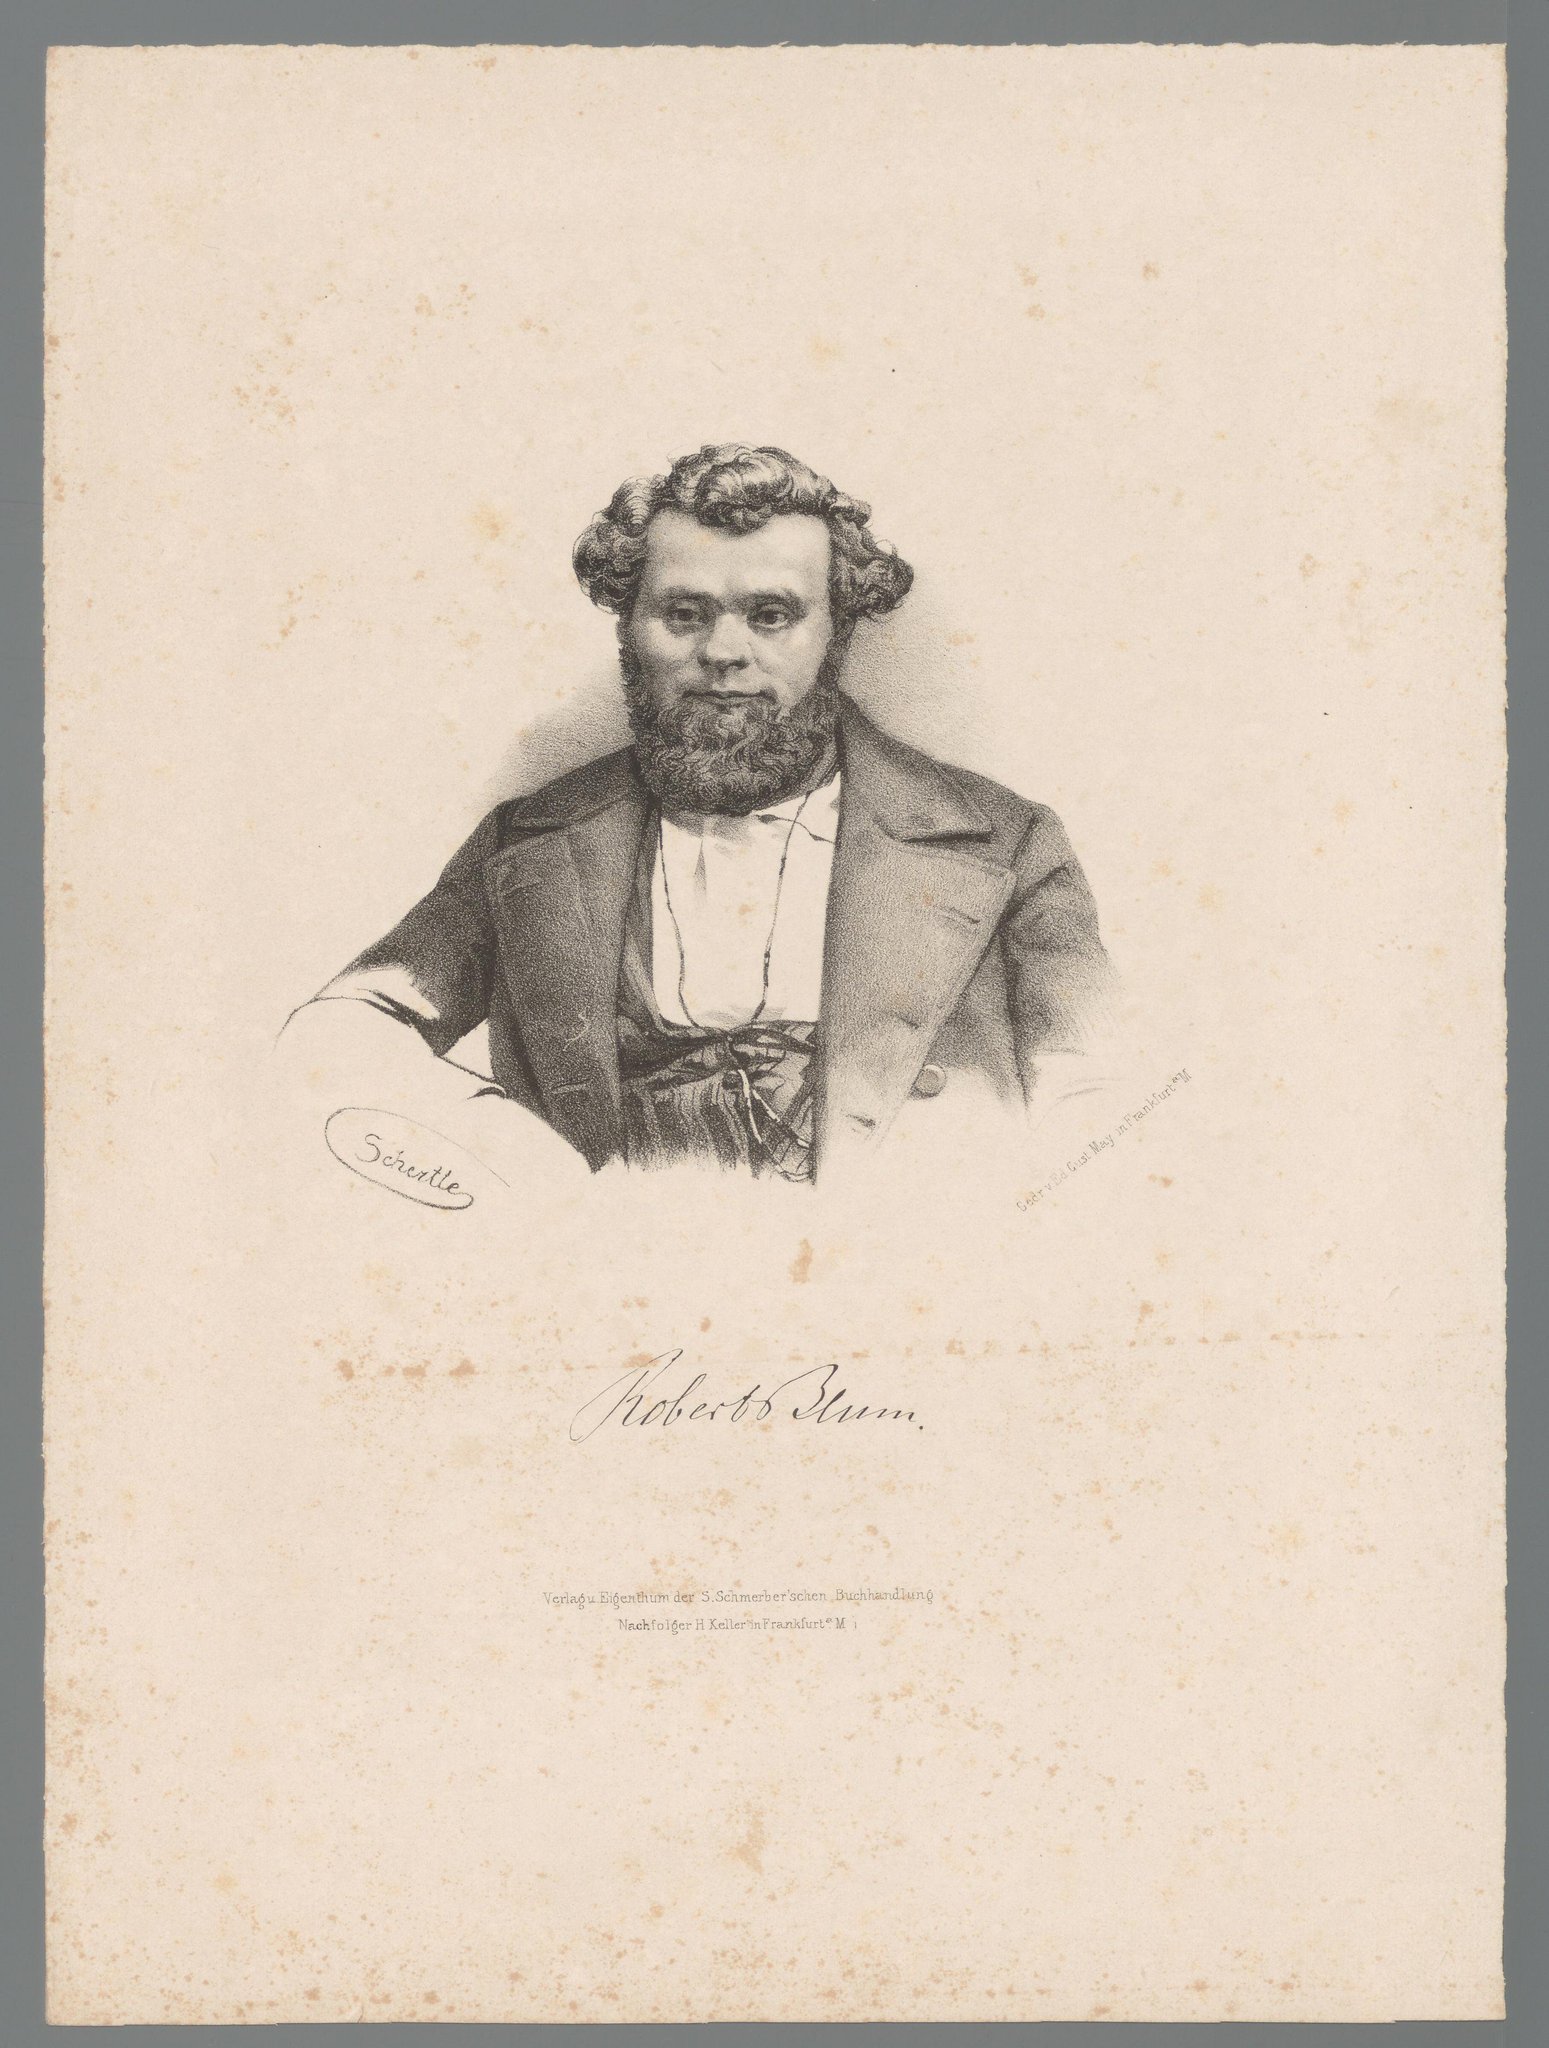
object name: print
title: Portret van Robert Blum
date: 1848-1849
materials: paper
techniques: lithograph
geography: frankfurt am main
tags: adult man, historical persons, beard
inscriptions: collector's mark: Lugt 2228